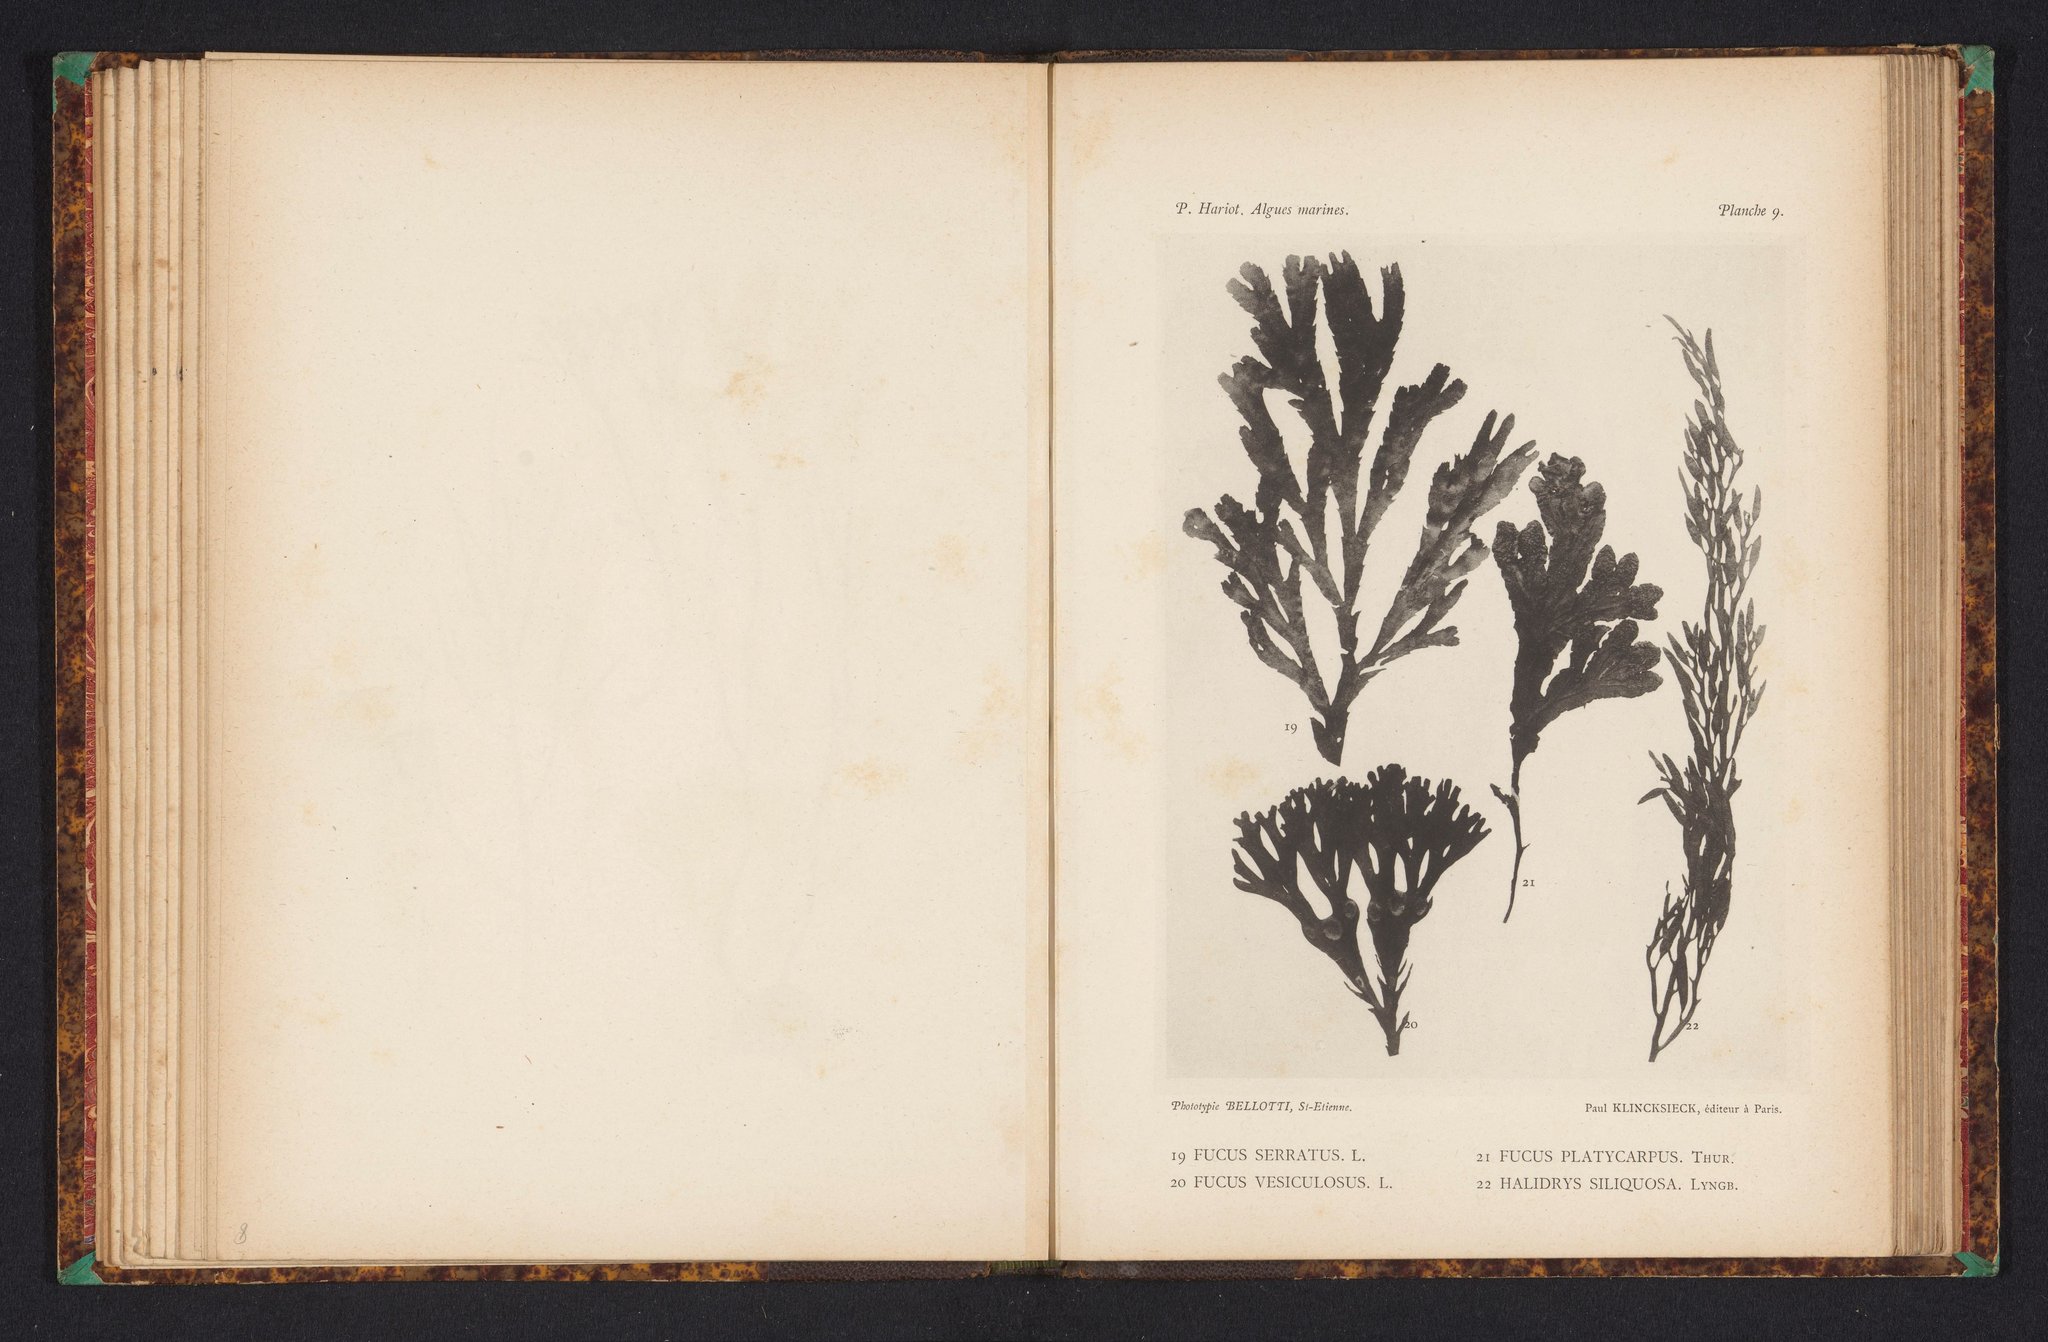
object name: page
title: Vier soorten zeewier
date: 1882-1892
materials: paper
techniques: photograph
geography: saint-étienne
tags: algae, seaweed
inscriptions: number: ‘Planche 9.’, inscription: ‘Fucus serratus (...) Halidrys siliquosa. Lyngb.’, number: ‘19 (...) 22’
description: (19) is gezaagde zee-eik, (20) is blaaswier, (21) is kleine zee-eik, (22) is hauwwier.